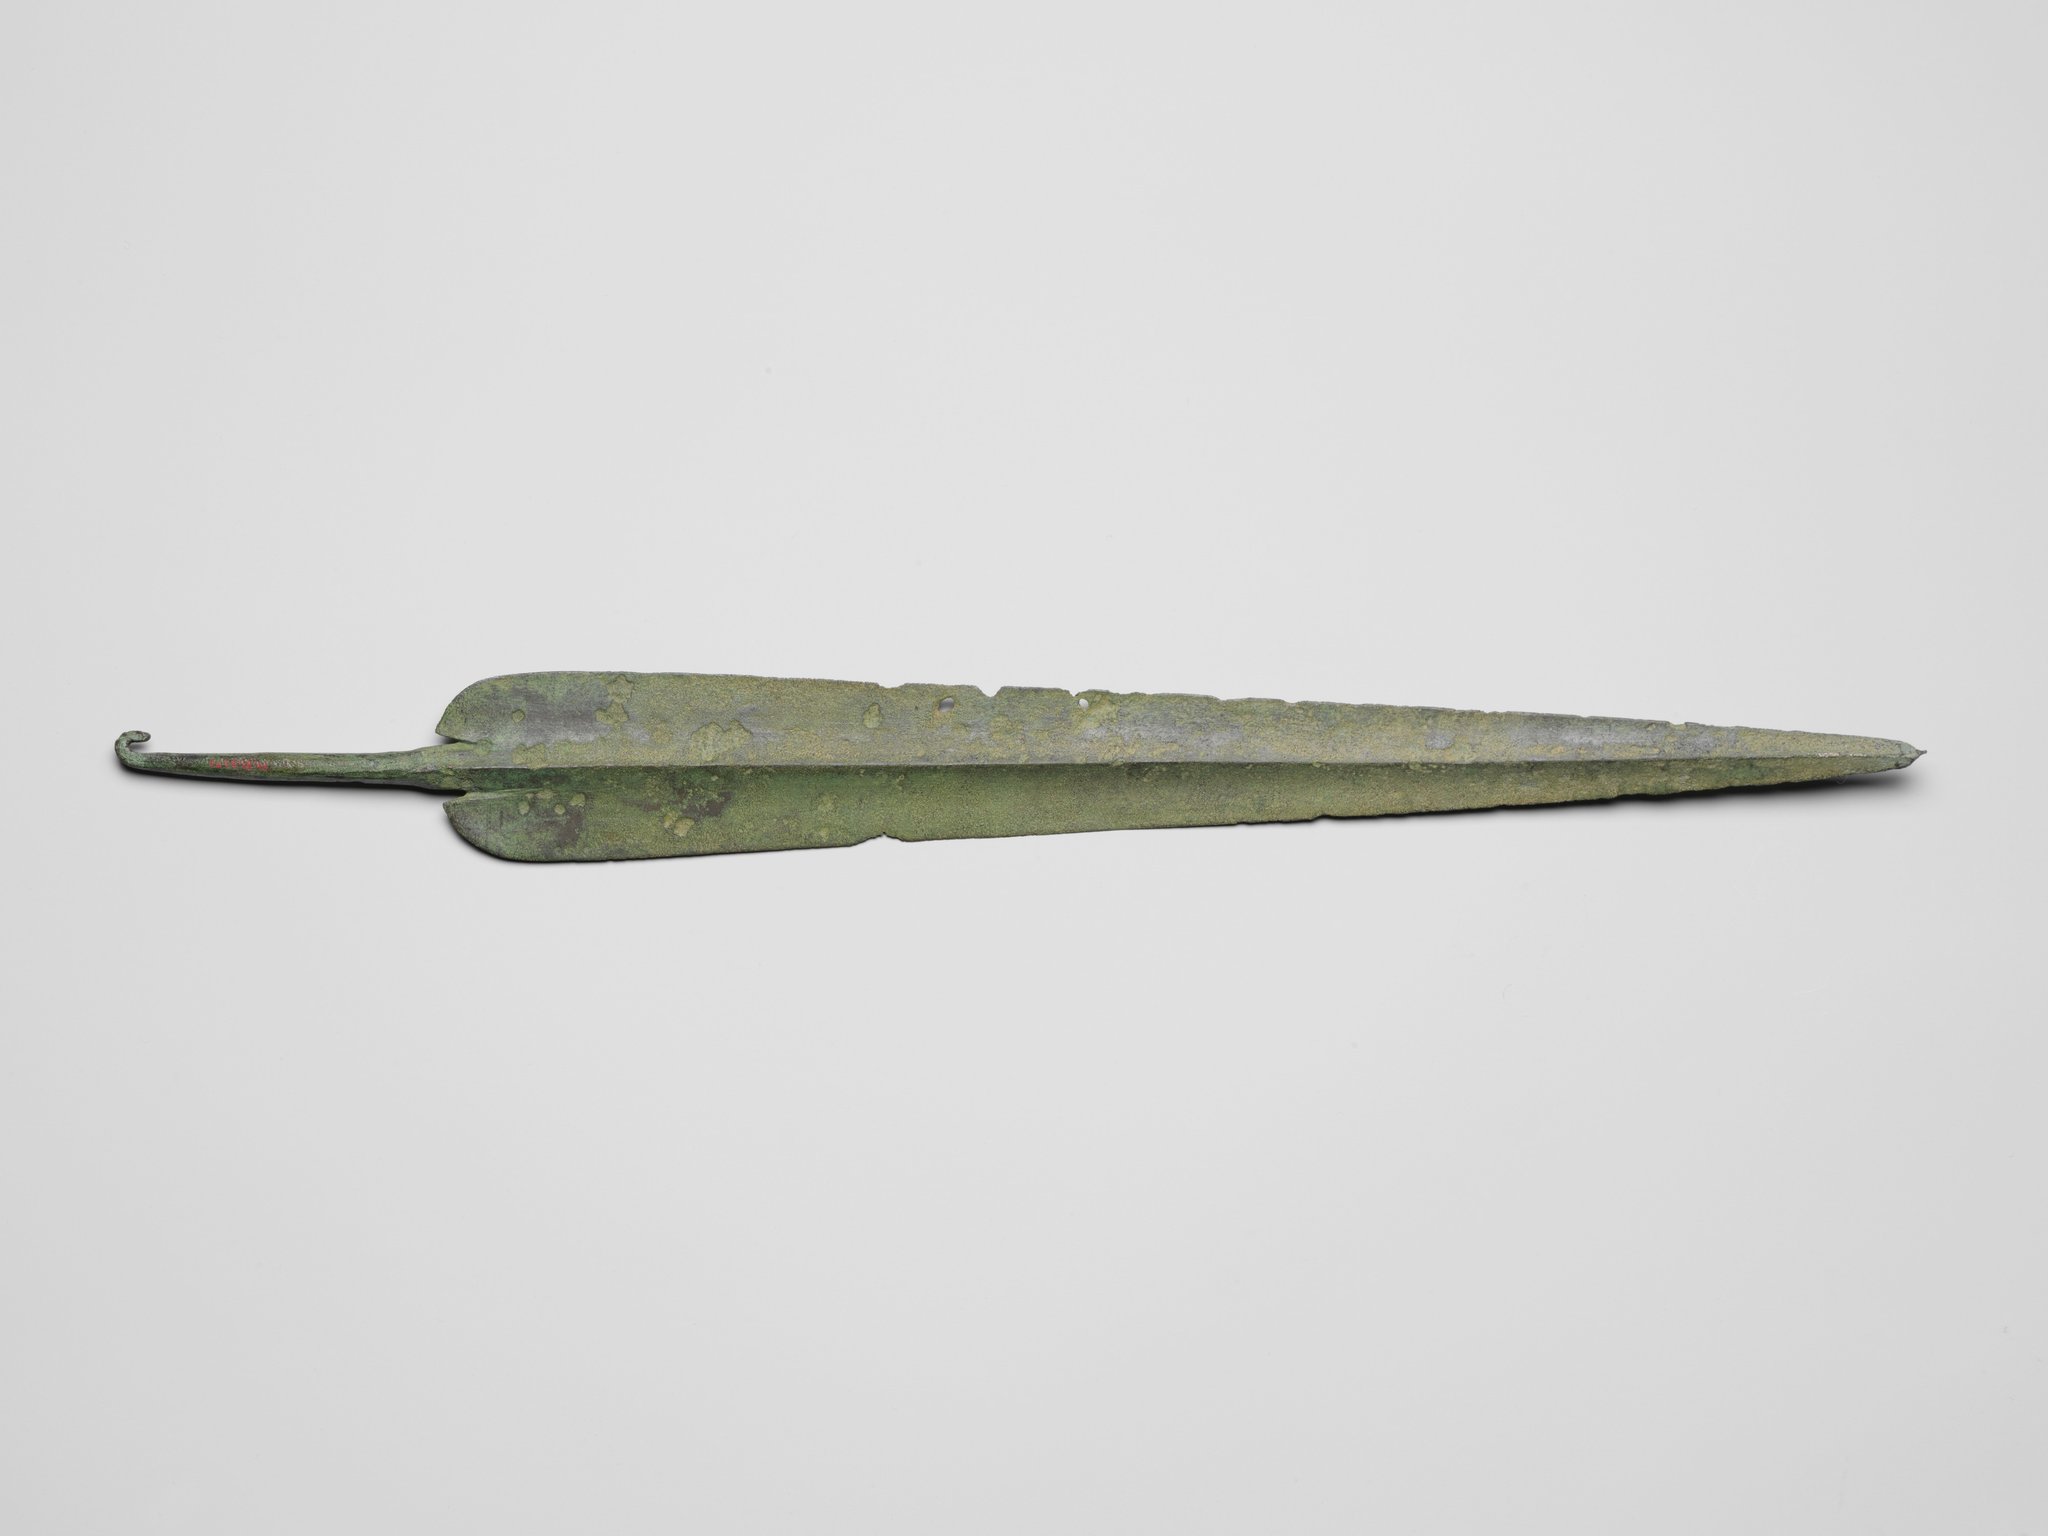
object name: dagger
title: Copper alloy spearhead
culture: cypriot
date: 2500-2000 BCE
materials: bronze